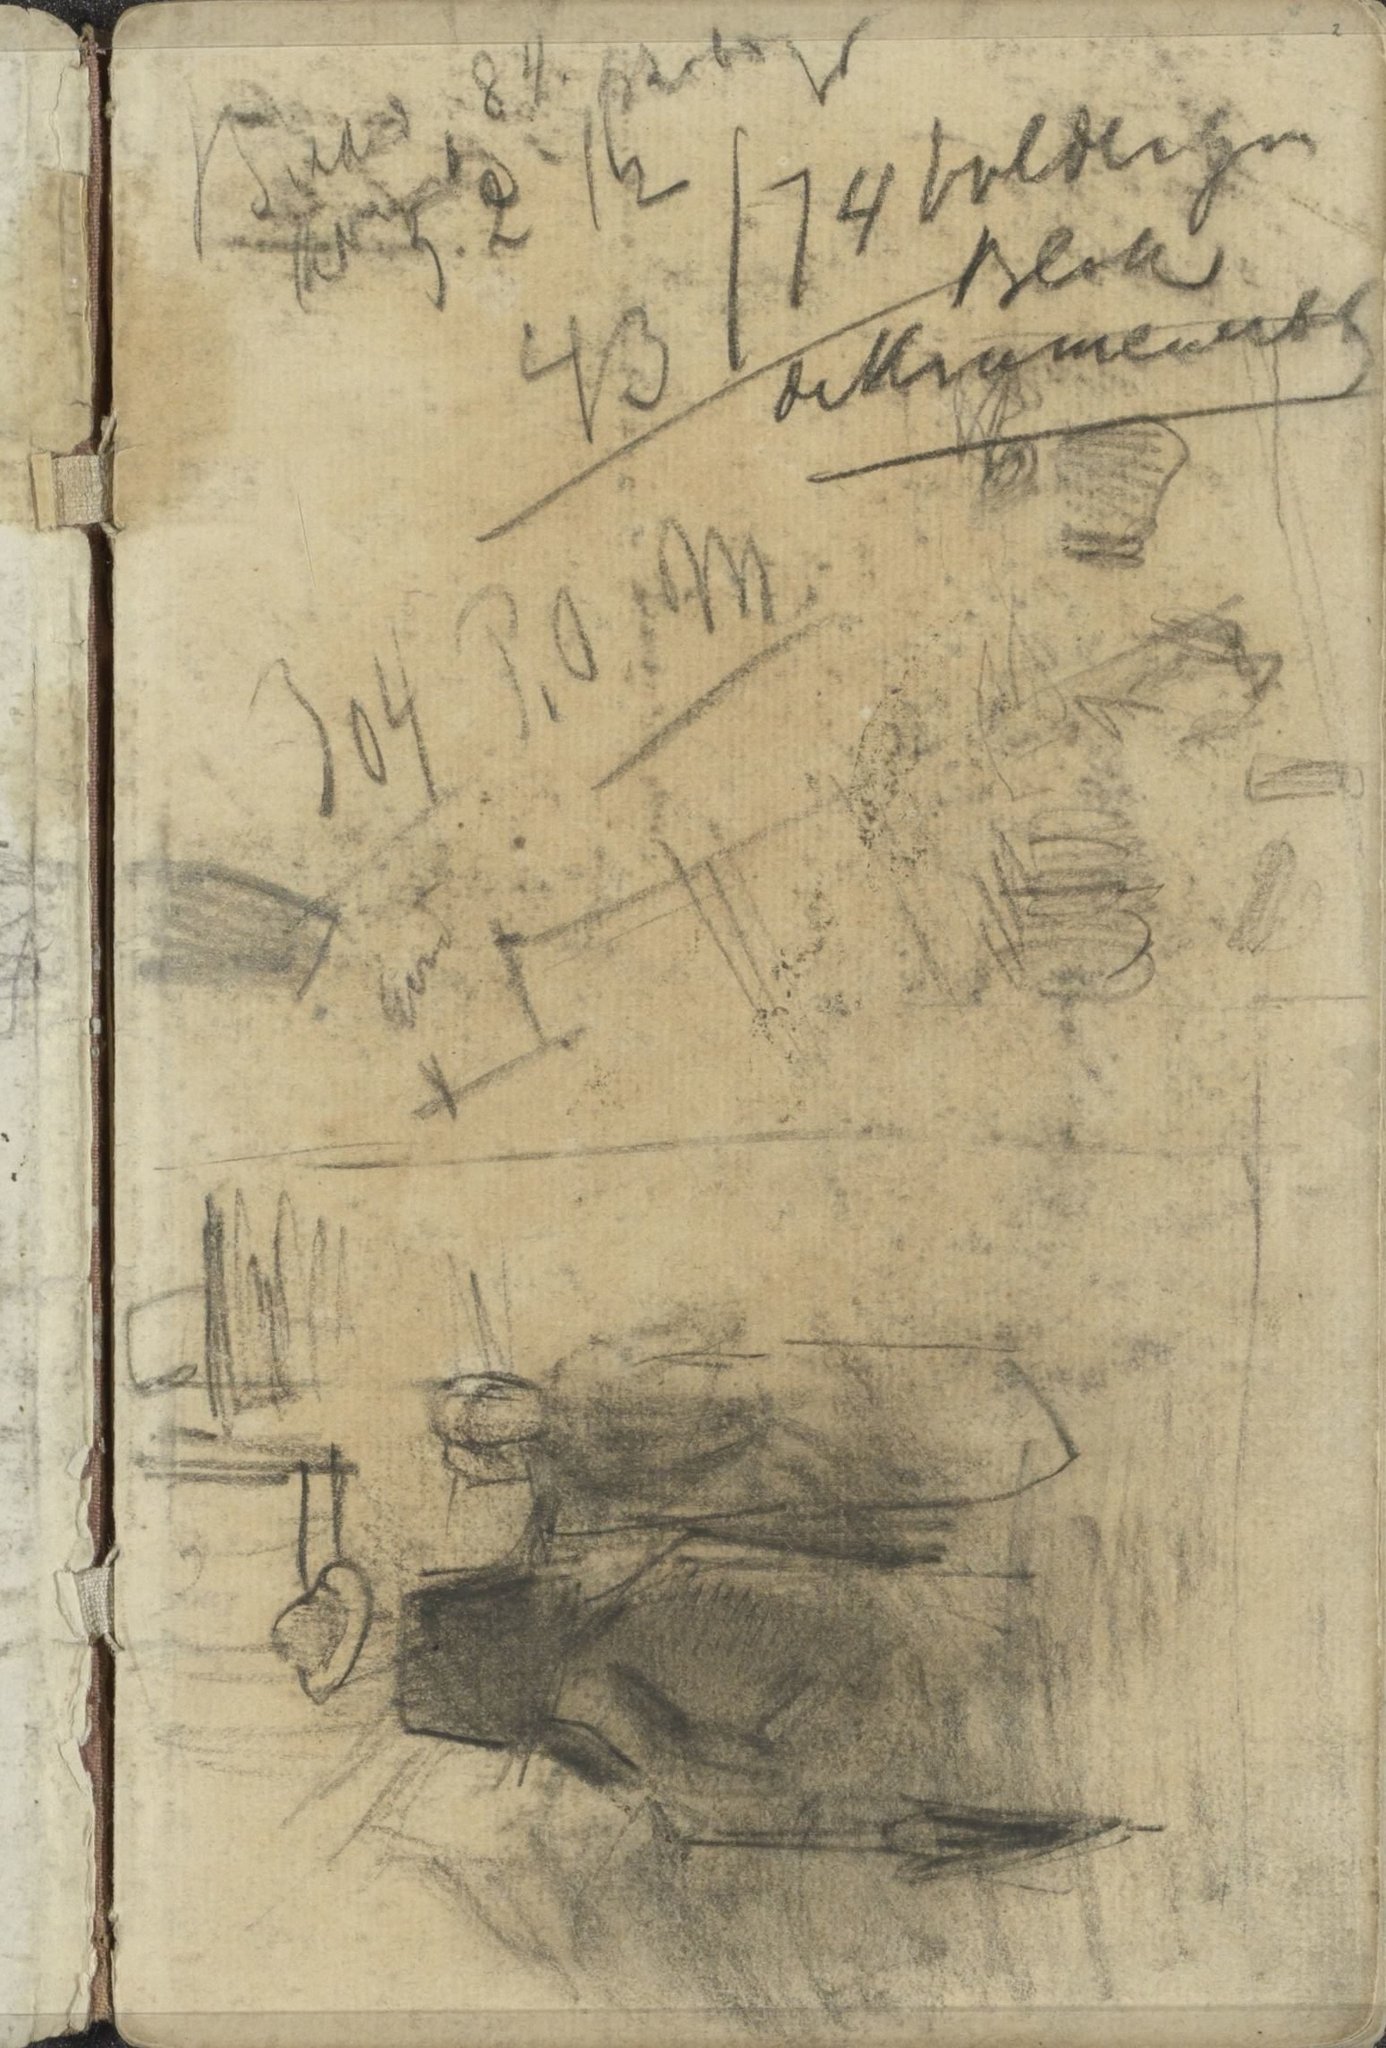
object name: sketchbook leaf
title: Studieblad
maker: george hendrik breitner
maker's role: draughtsman, painter, print maker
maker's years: 1857-1923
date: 1880-1882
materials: chalk, paper, pencil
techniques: stumping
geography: the hague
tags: adult woman, child, umbrella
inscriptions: annotation: ‘[...]’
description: Onder andere een vrouw met kind. Pagina 2 uit een schetsboek met 19 bladen.